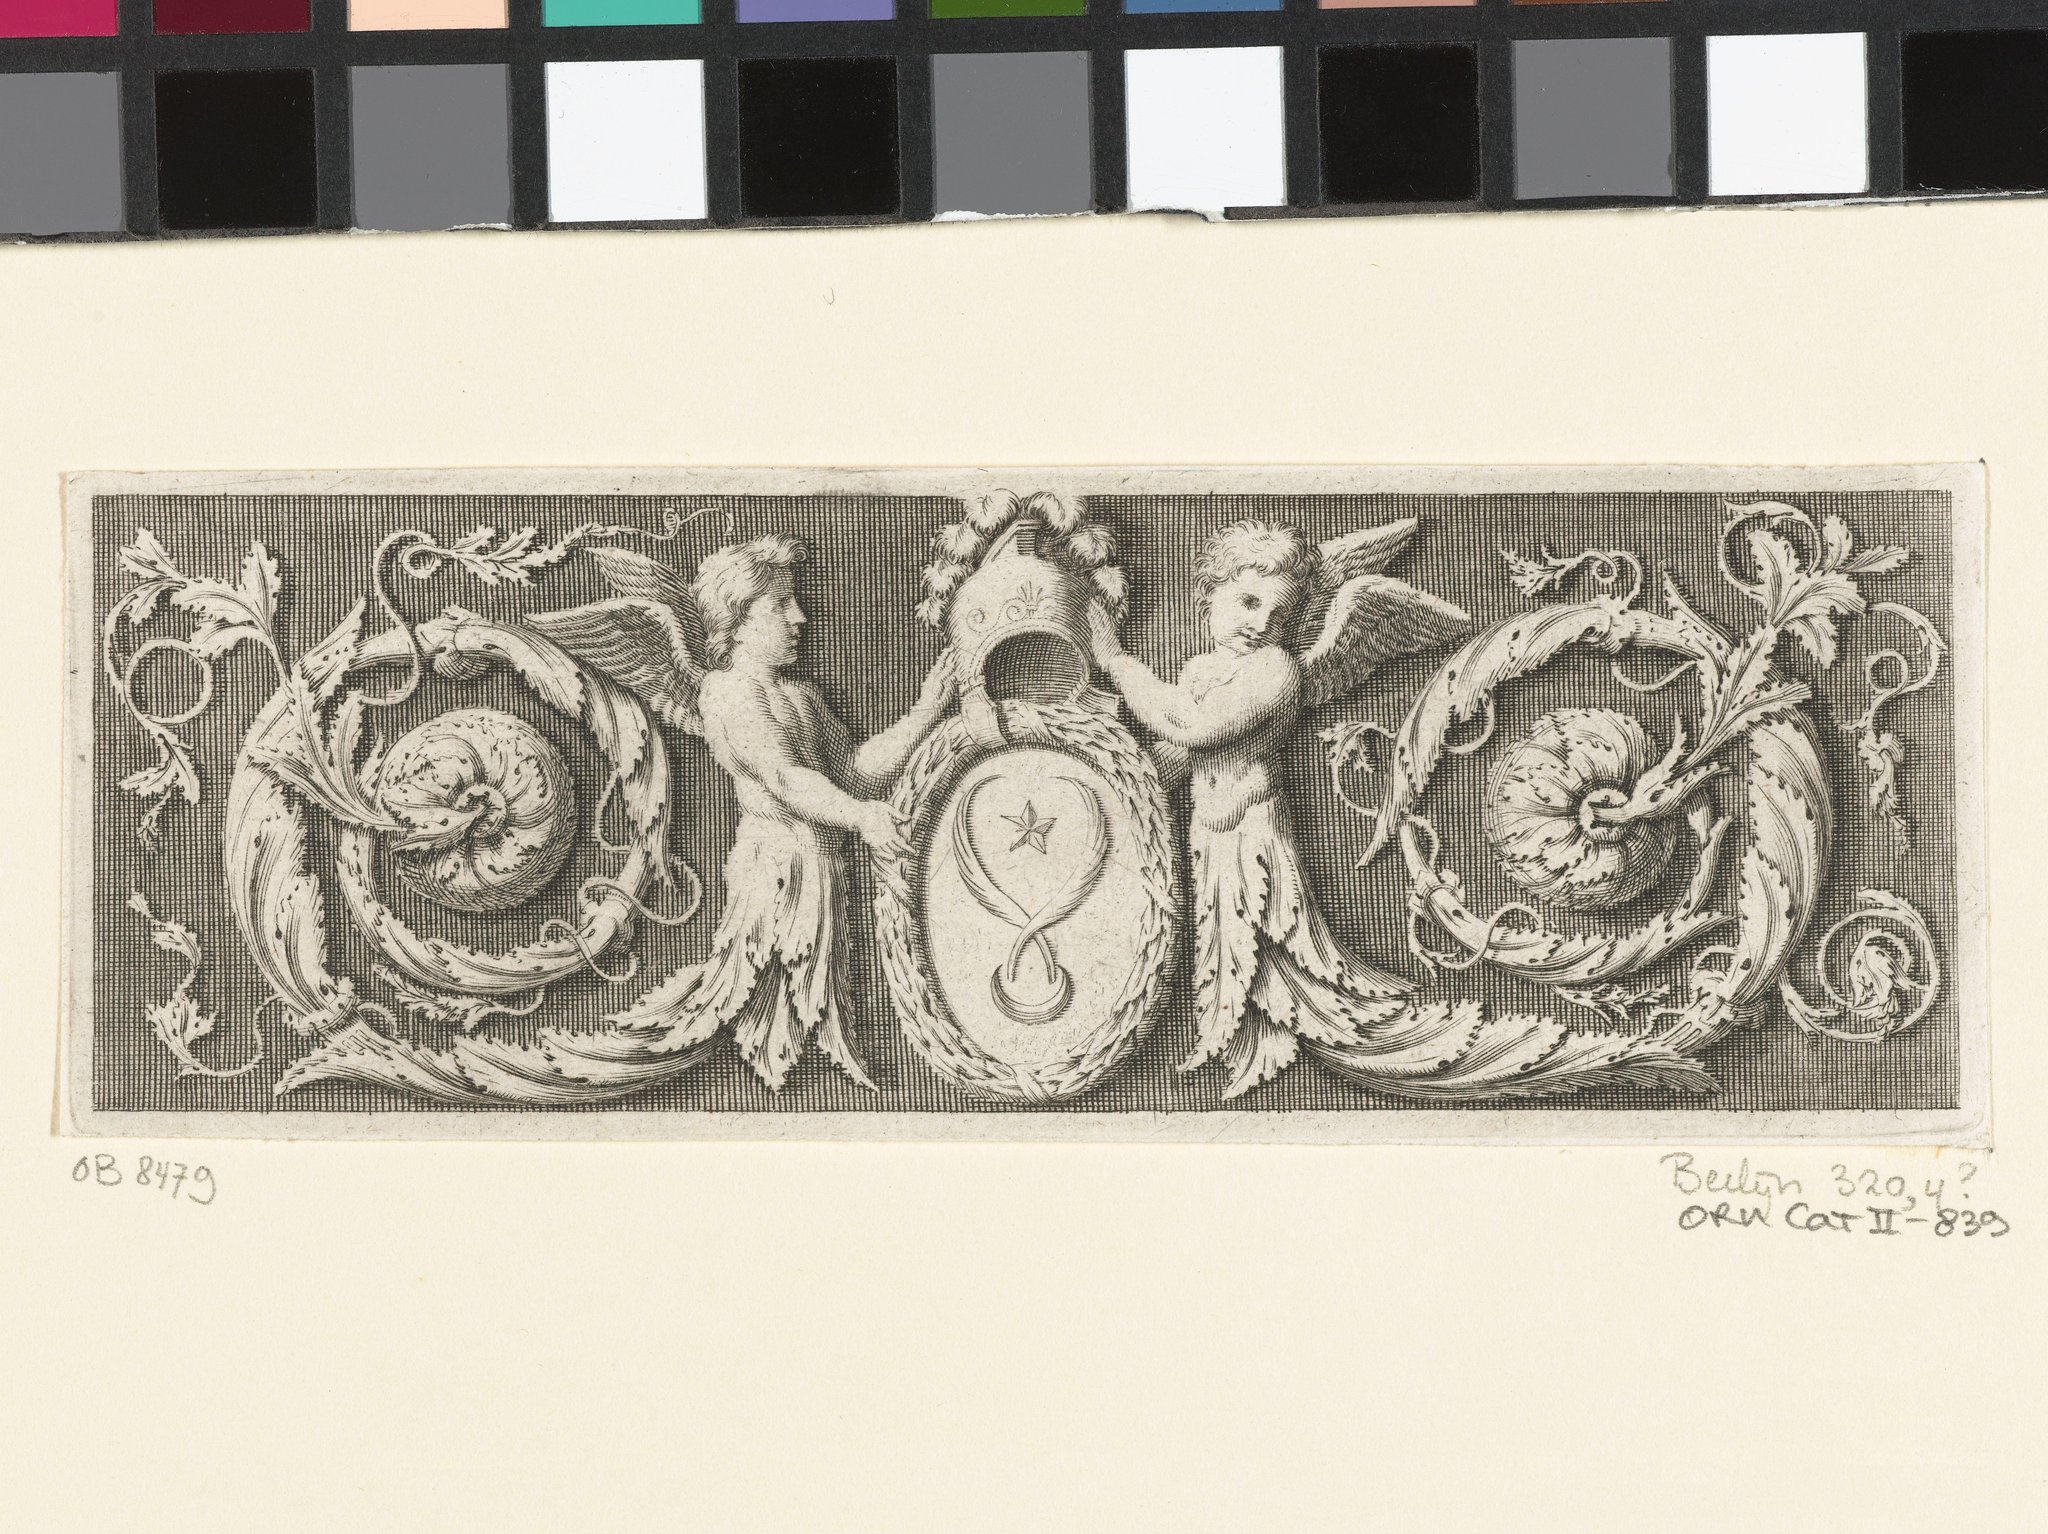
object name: print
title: Vignetten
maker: Anonymous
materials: paper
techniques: engraving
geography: paris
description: Vignet. Het medaillon wordt aan weerskanten vastgehouden door een putto, wiens bovenlichaam ontspruit uit een bladrank. In het medaillon staan twee gekruiste palmbladeren, een ster en een halve maan. Een van 18 bladen.